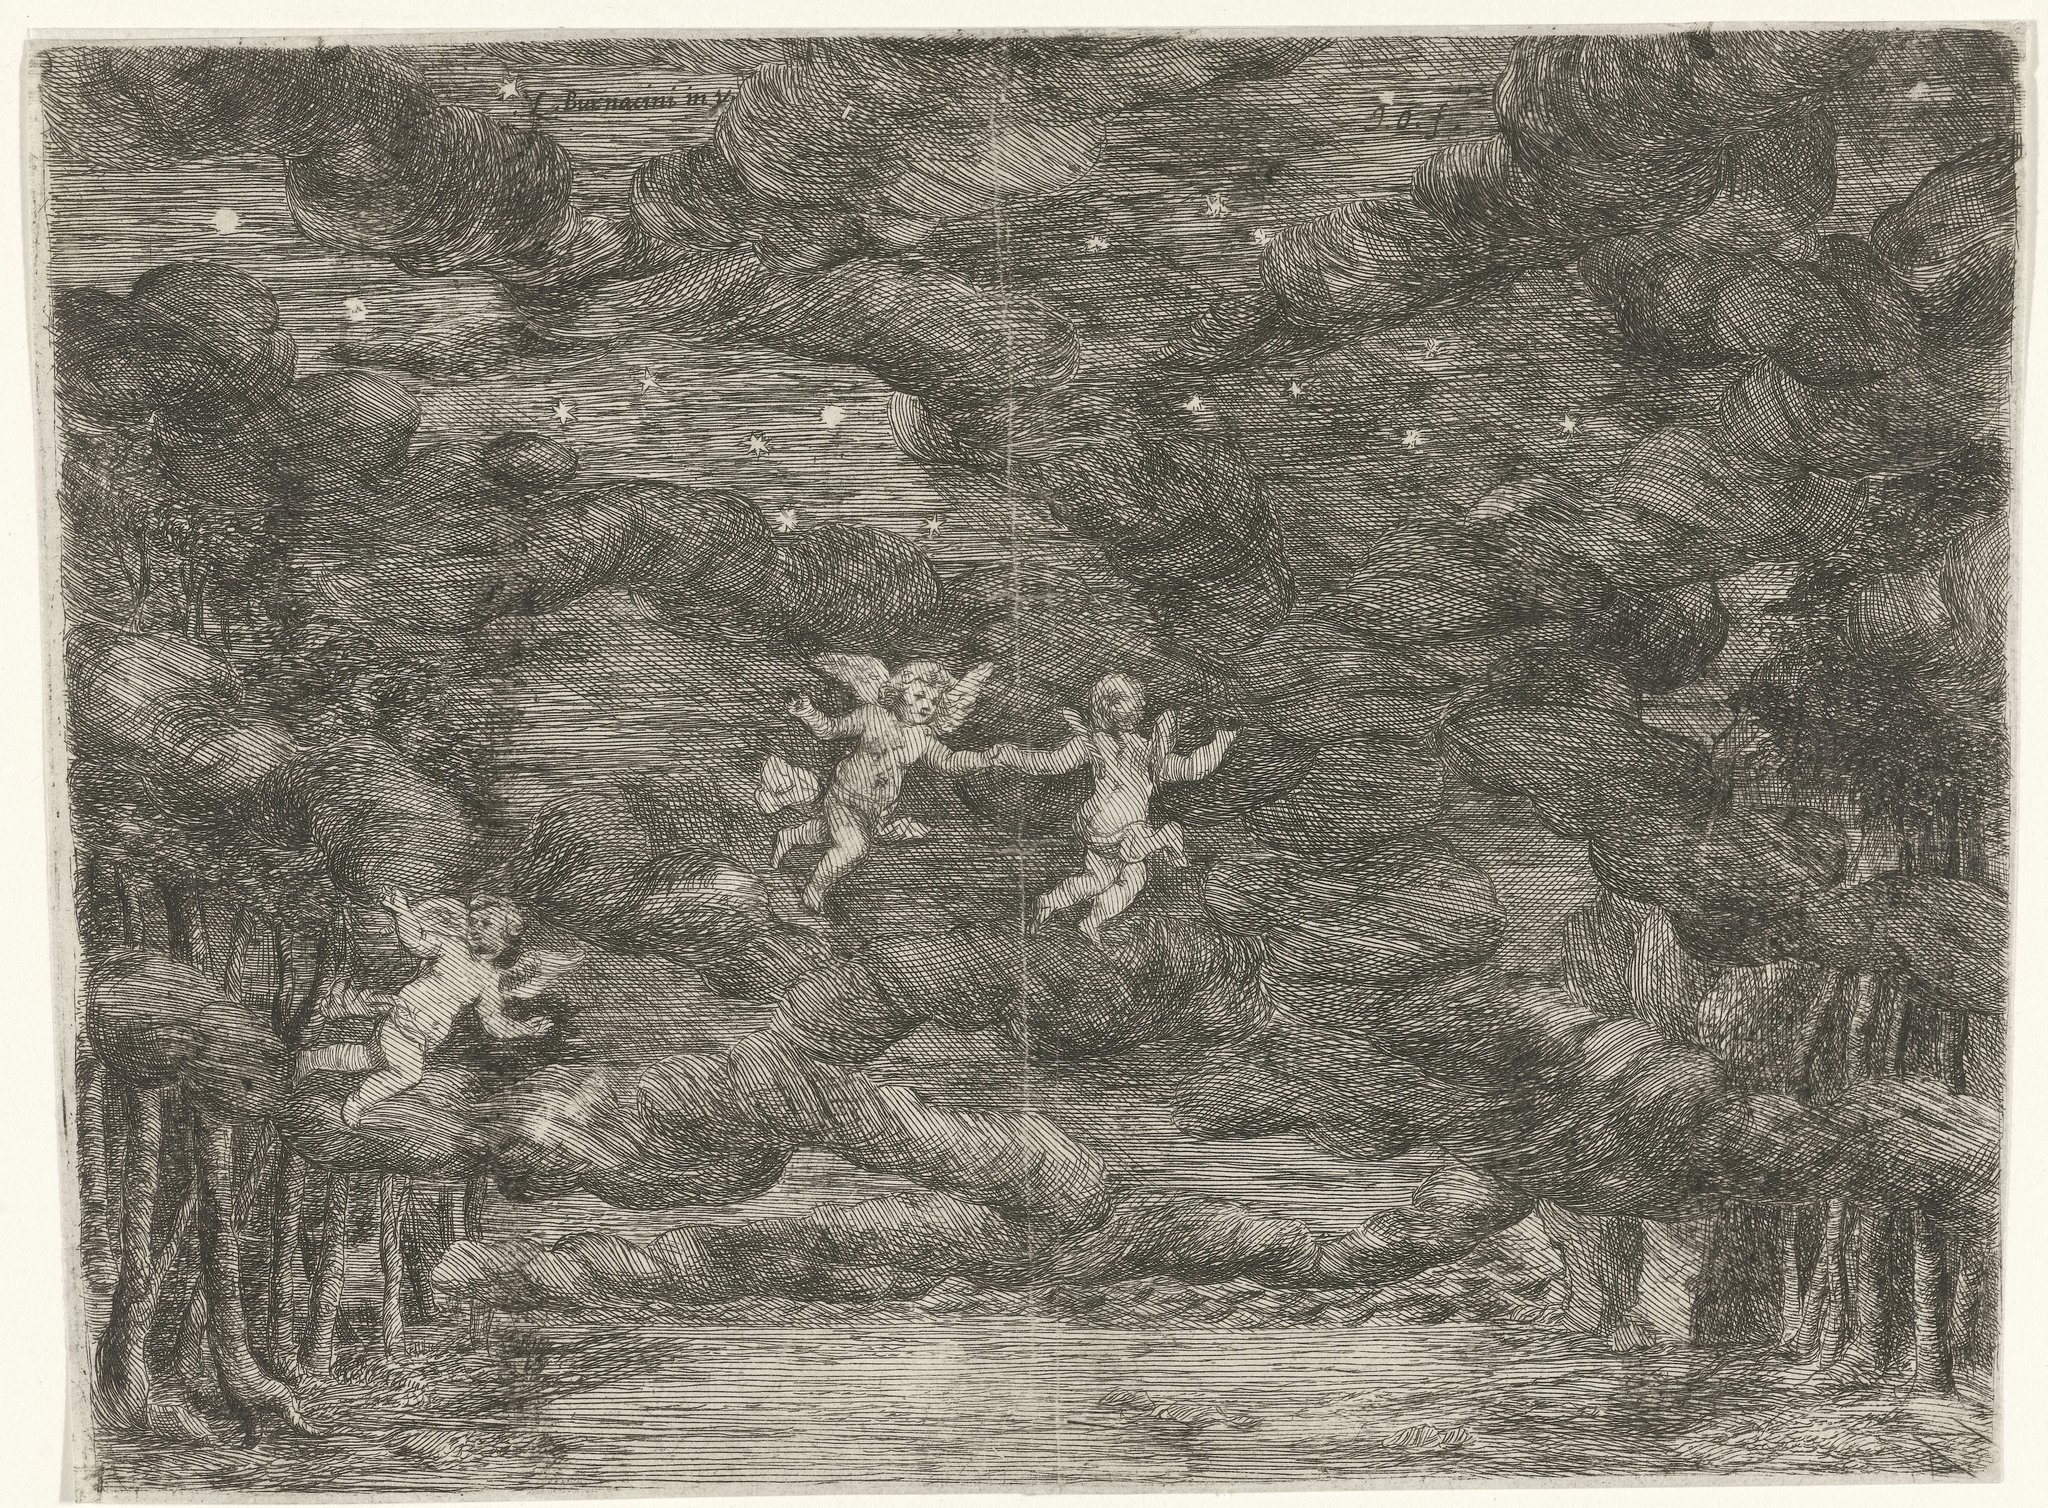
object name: print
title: Toneeldecor met engelen aan de nachtelijke hemel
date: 1663-1674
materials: paper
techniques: etching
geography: vienna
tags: set, scenery ~ stage, night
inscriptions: collector's mark: Lugt 2228